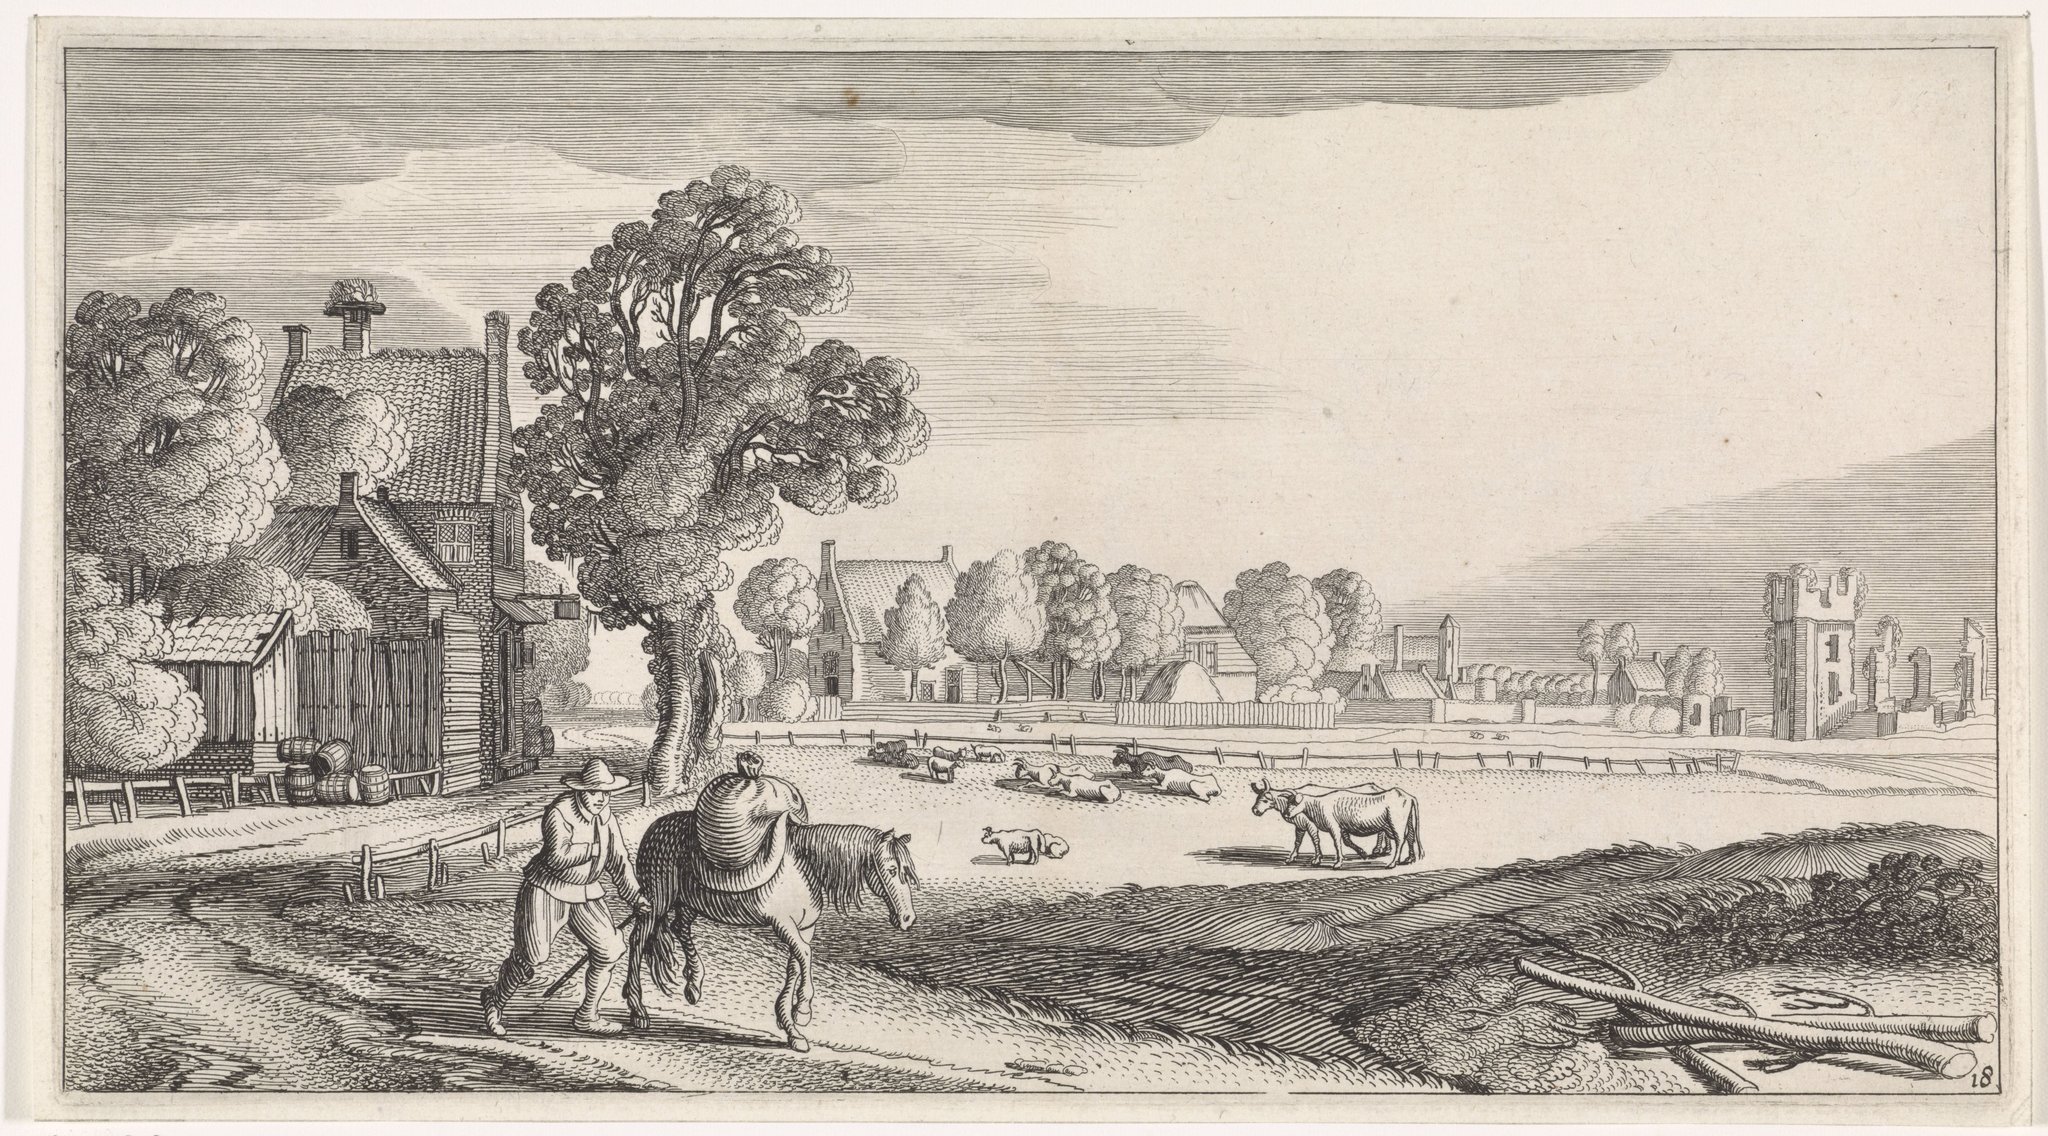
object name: print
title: Boer met pakpaard op een landweg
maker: jan van de velde (ii)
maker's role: draughtsman, painter, print maker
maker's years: 1593-1641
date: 1639-1641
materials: paper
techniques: etching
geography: northern netherlands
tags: pack-animal, village, landscape with ruins, bovine cattle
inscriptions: collector's mark: Lugt 964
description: Een boer met een pakpaard op een pad bij een dorp. In het midden een weide met vee en rechts op de achtergrond een ruïne (van het Huis ter Kleef te Haarlem?). Achttiende prent van een serie met 36 prenten van landschappen, verdeeld over zes delen.